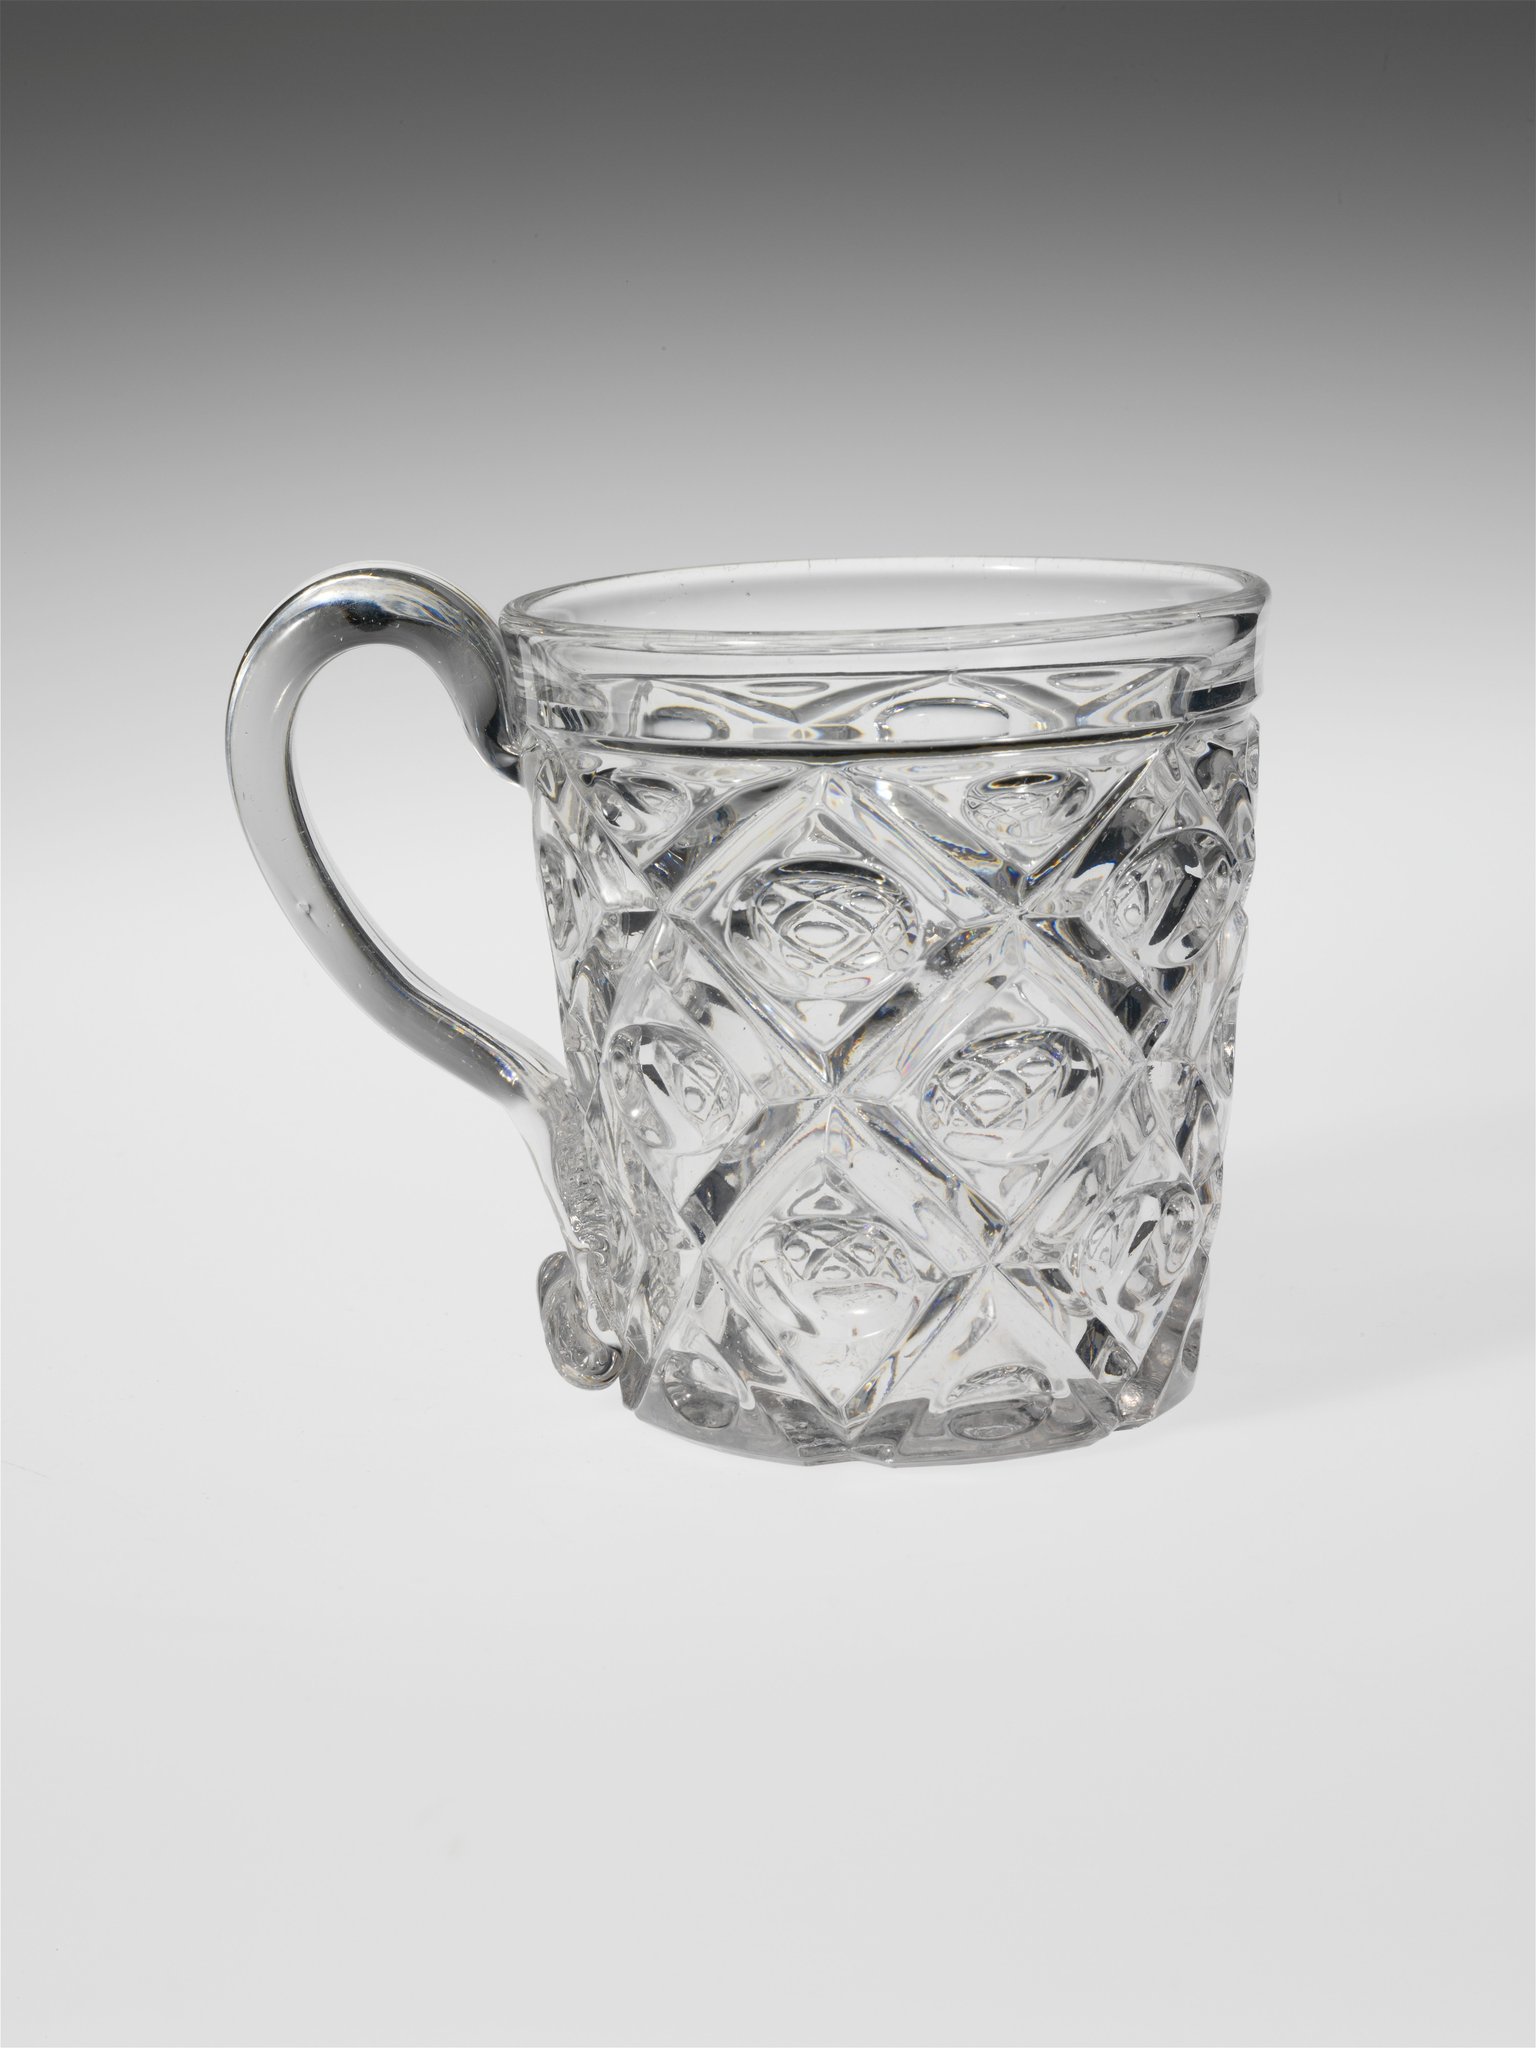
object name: mug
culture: american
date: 1850-1870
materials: diamond, glass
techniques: pressed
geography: united states